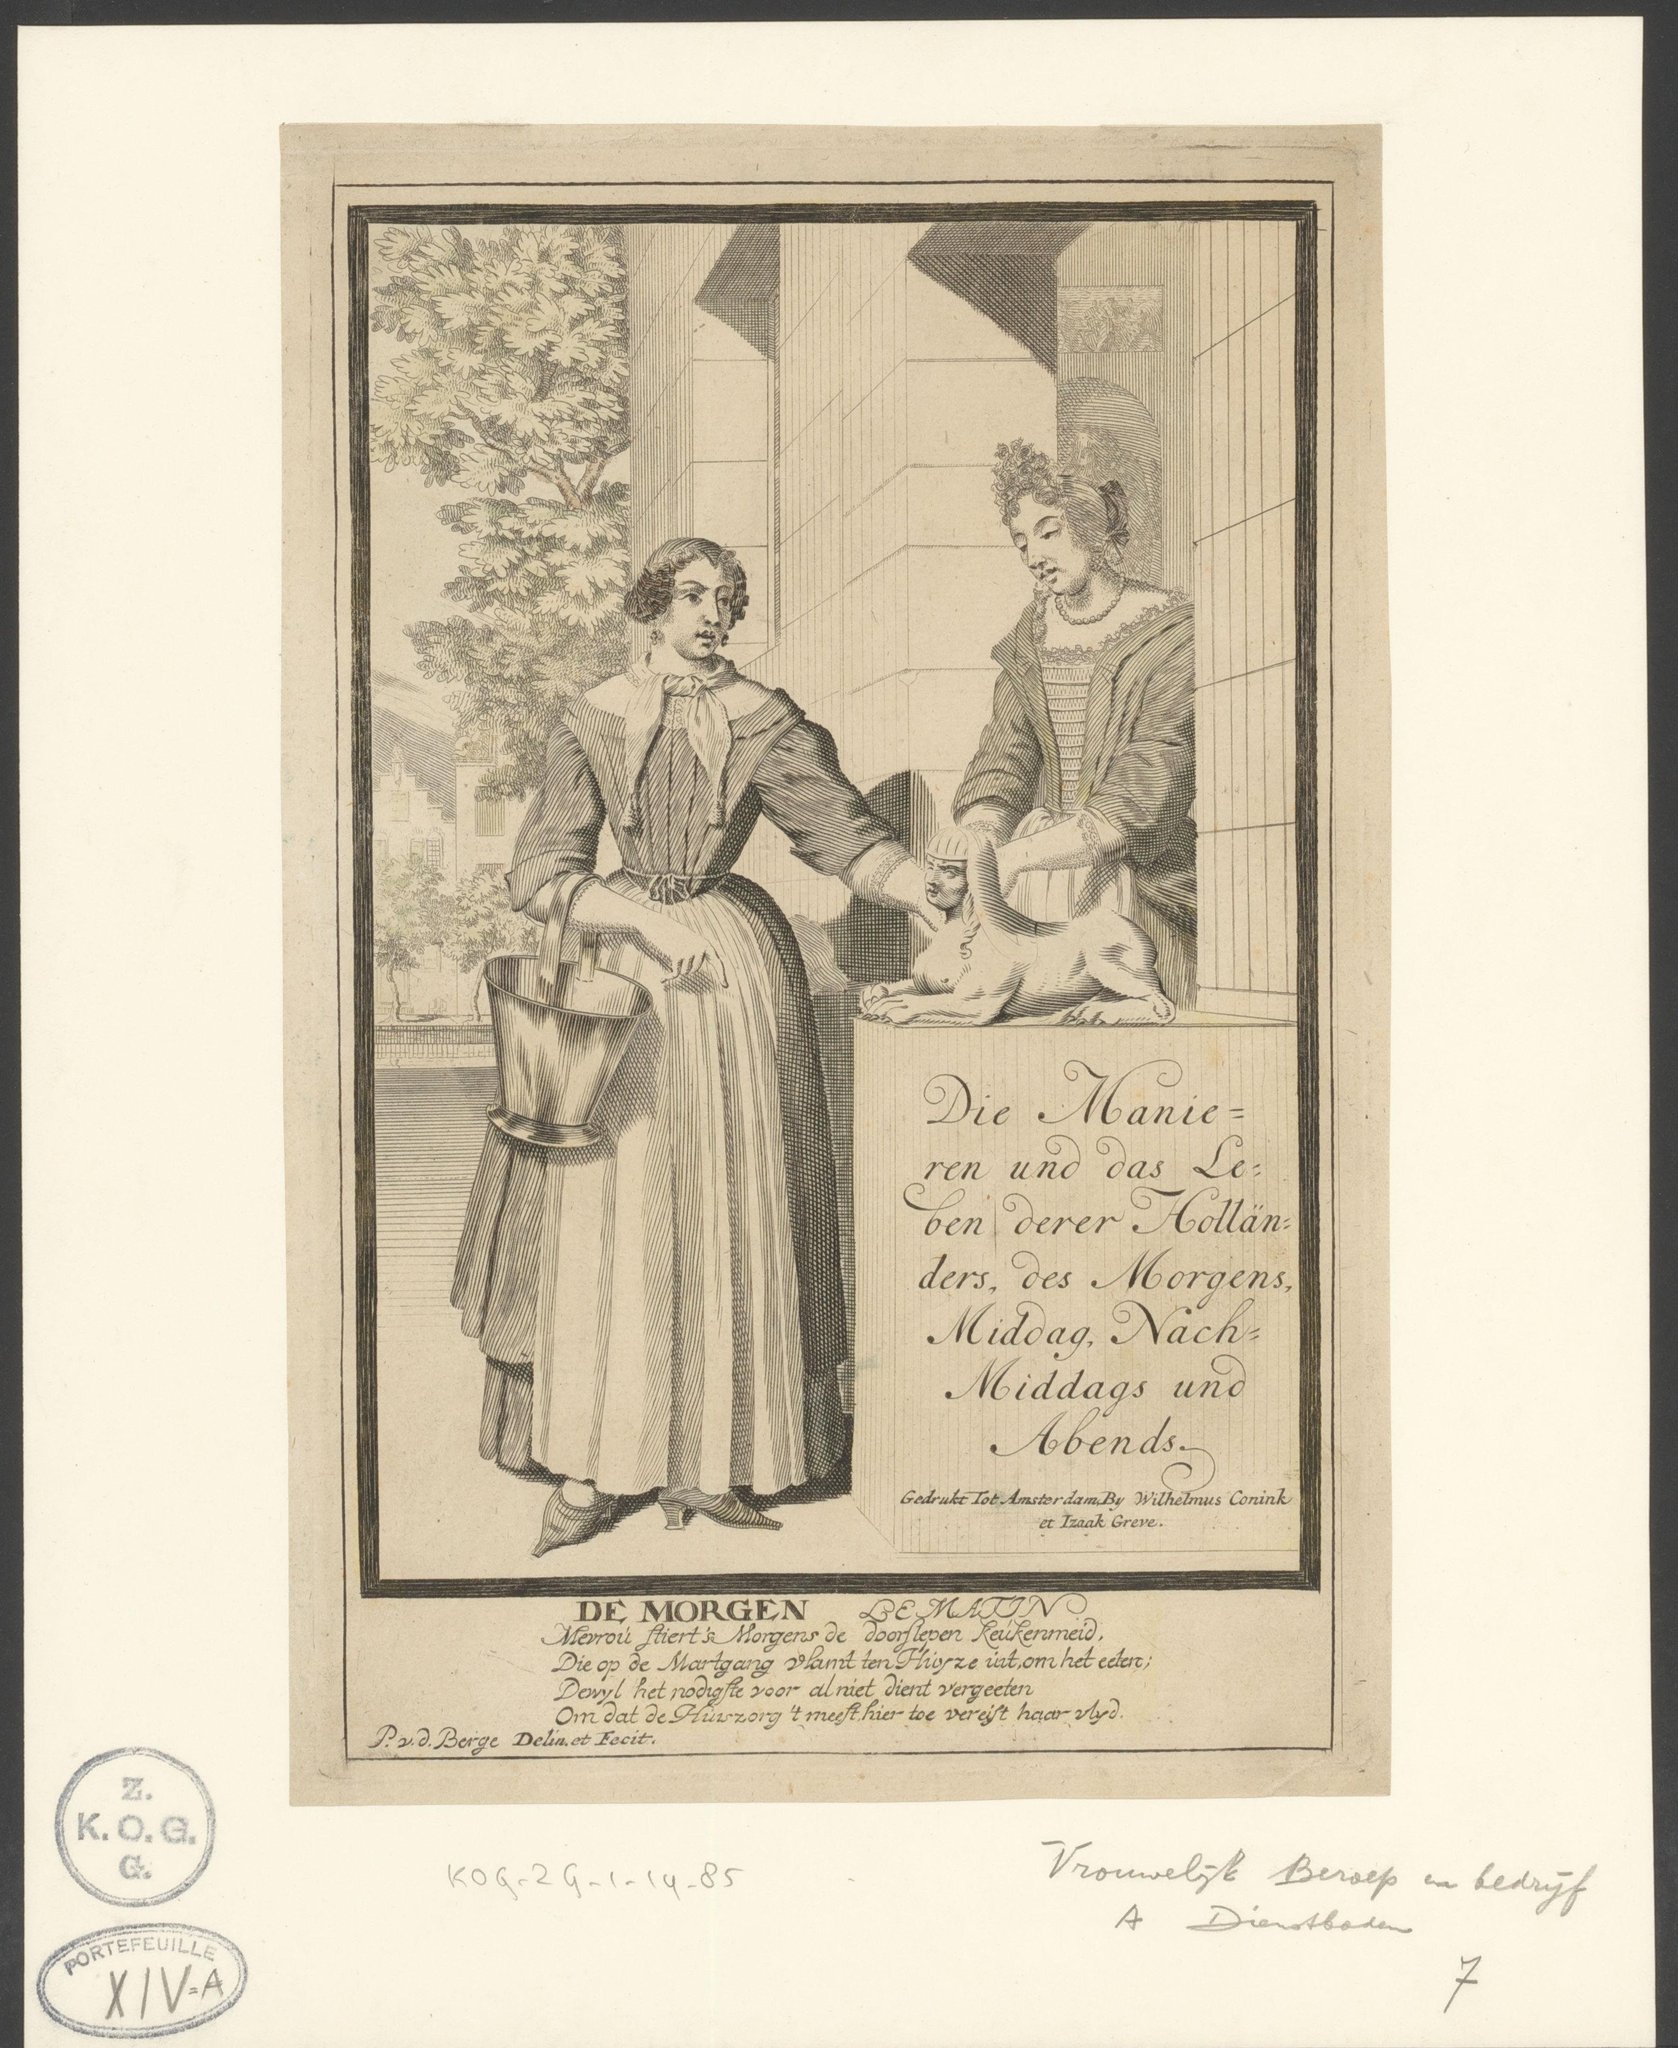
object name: print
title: Die Manieren und das Leben derer Holländers, des Morgens, Middag, Nachmiddags und Abends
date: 1718-1737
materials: paper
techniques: engraving, etching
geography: amsterdam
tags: morning, kitchen-maid, kitchen servant, housewife giving orders to servants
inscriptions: collector's mark, collector's mark: Lugt 1641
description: Titelprent voor de serie De vier tijden van de dag. Een dame staat in de deuropening van haar huis. Boven de titel ligt een beeld van een sfinx. Voor de vrouw staat een keukenmeid met een emmer aan de arm, die naar de markt wordt gestuurd. Onder de prent een vers van vier regels in het Nederlands. Onderwerpsrubrieken binnen de Atlas Zeden en Gewoonten: Beroep en bedrijf. Vrouwelijk beroep en bedrijf. Dienstboden.